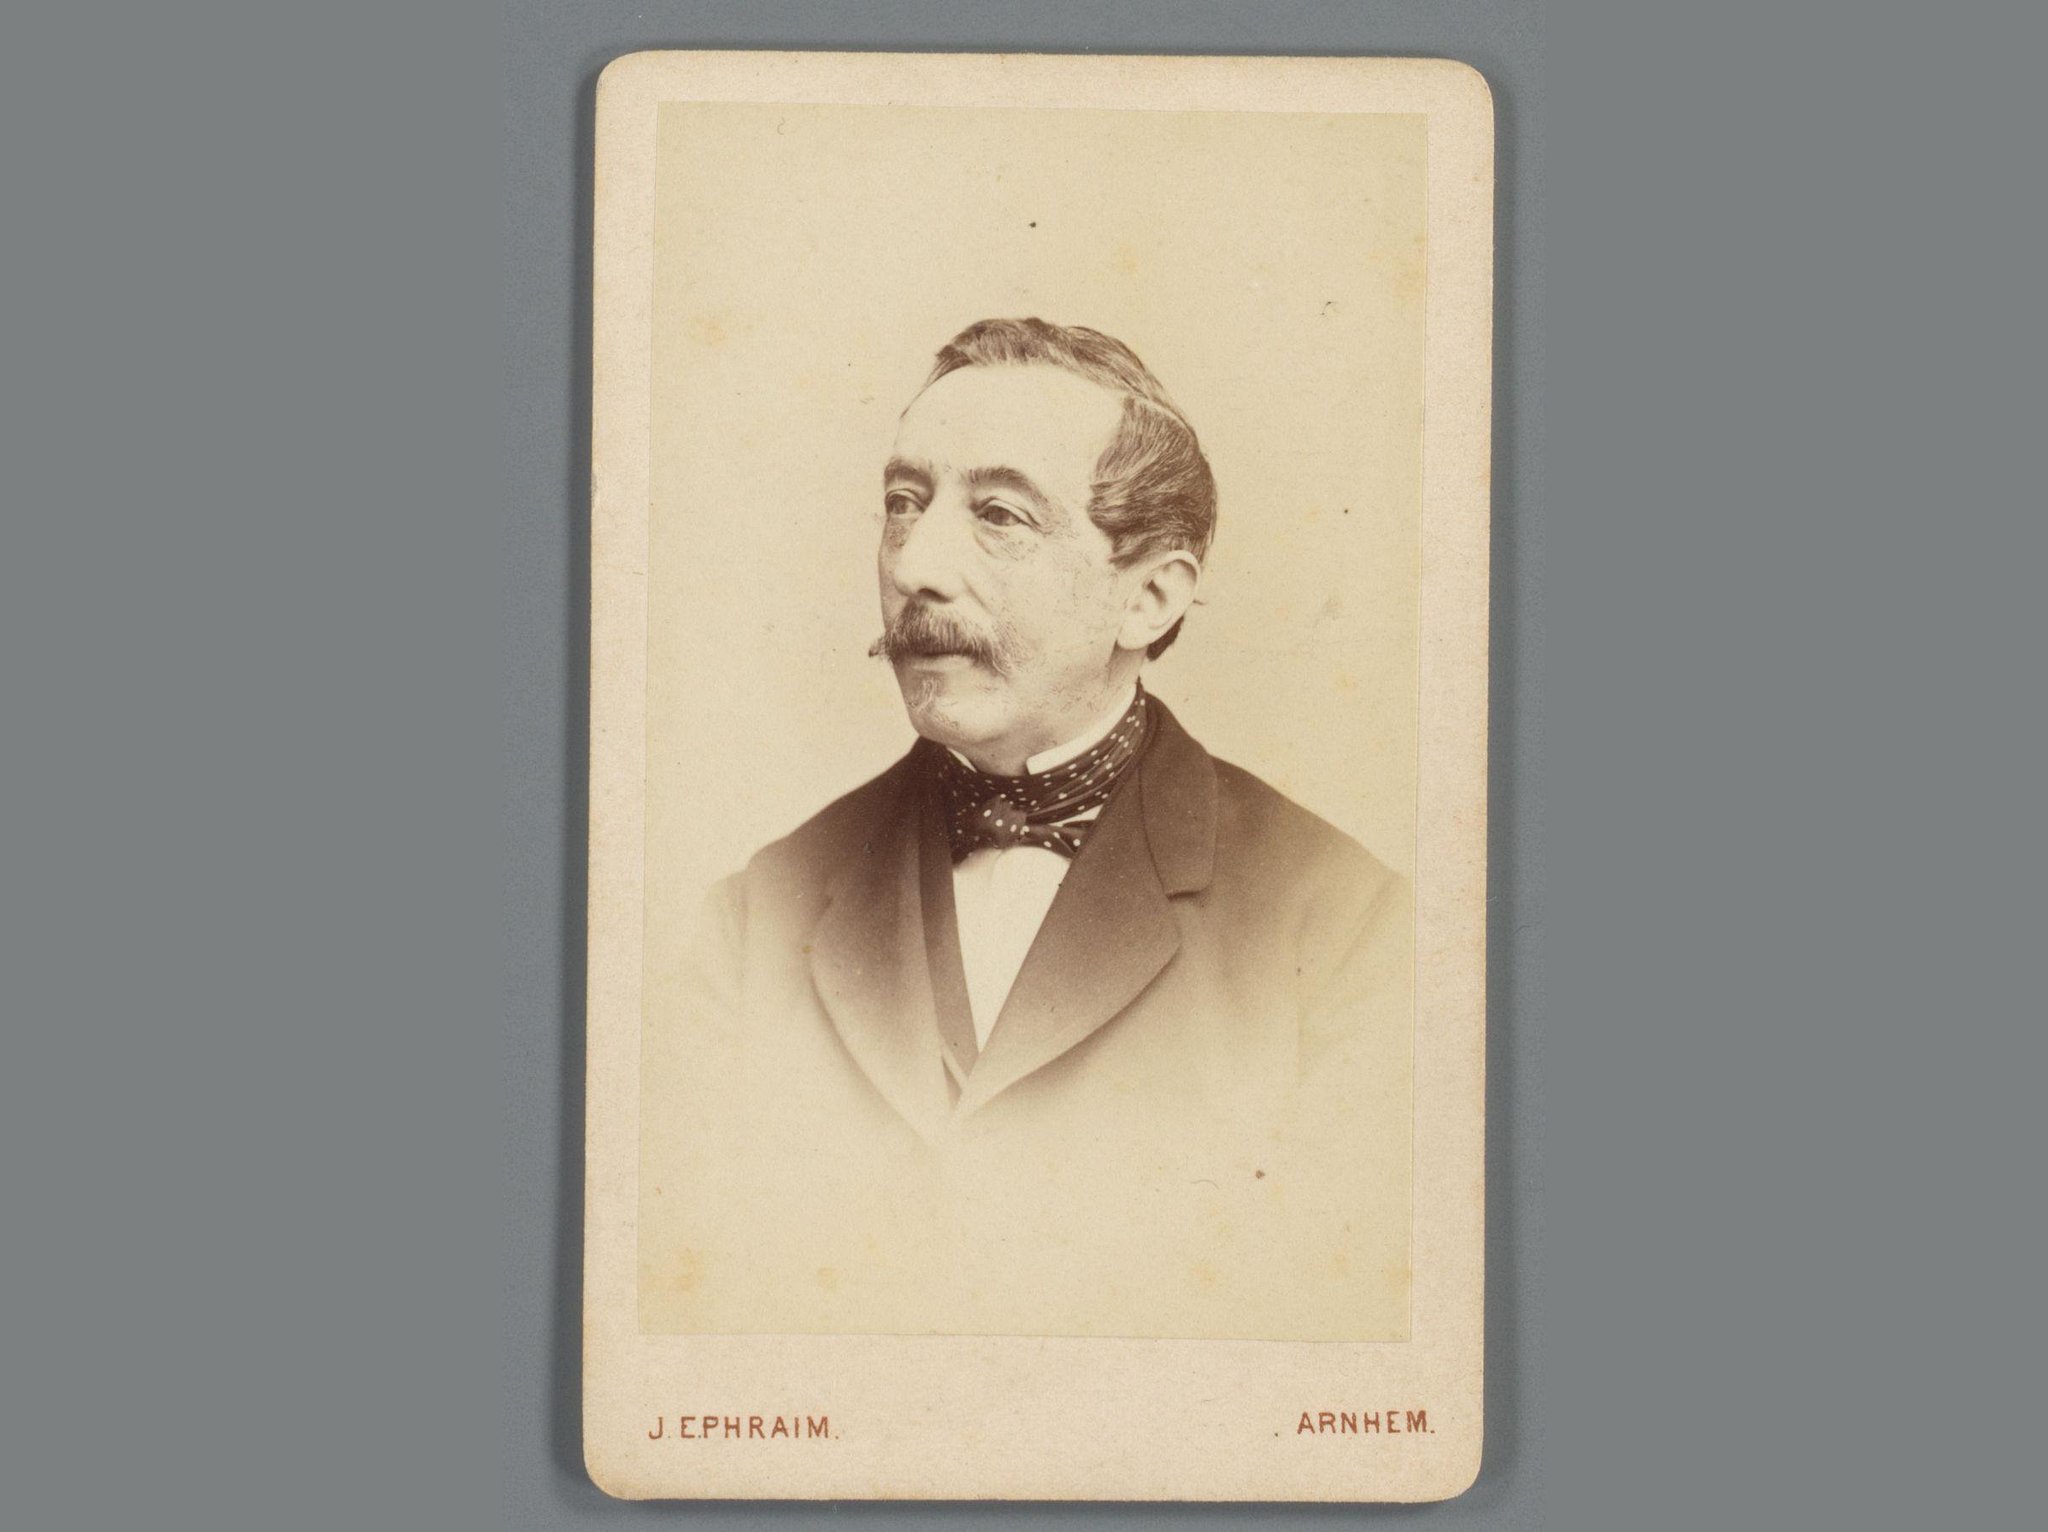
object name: carte de visite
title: Portret van een onbekende man uit de familie en de kring van Eugene van Delden en Belle van Delden-Denninghof Stelling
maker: johannes ephraim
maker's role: fotograaf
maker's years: 1838-1921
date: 1866-1878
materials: cardboard, paper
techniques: albumen print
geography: arnhem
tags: historical persons not known by name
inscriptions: inscription: ‘Photographisch/ Atelier/ van/ J. Ephraim jr./ Arnhem/ Rynkade 312’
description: Portret uit de kring van Eugene van Delden (Hartapoera, 1865 - Den Haag, 1954) en Belle van Delden-Denninghof Stelling (Batavia, 1870 - Den Haag, 1947).